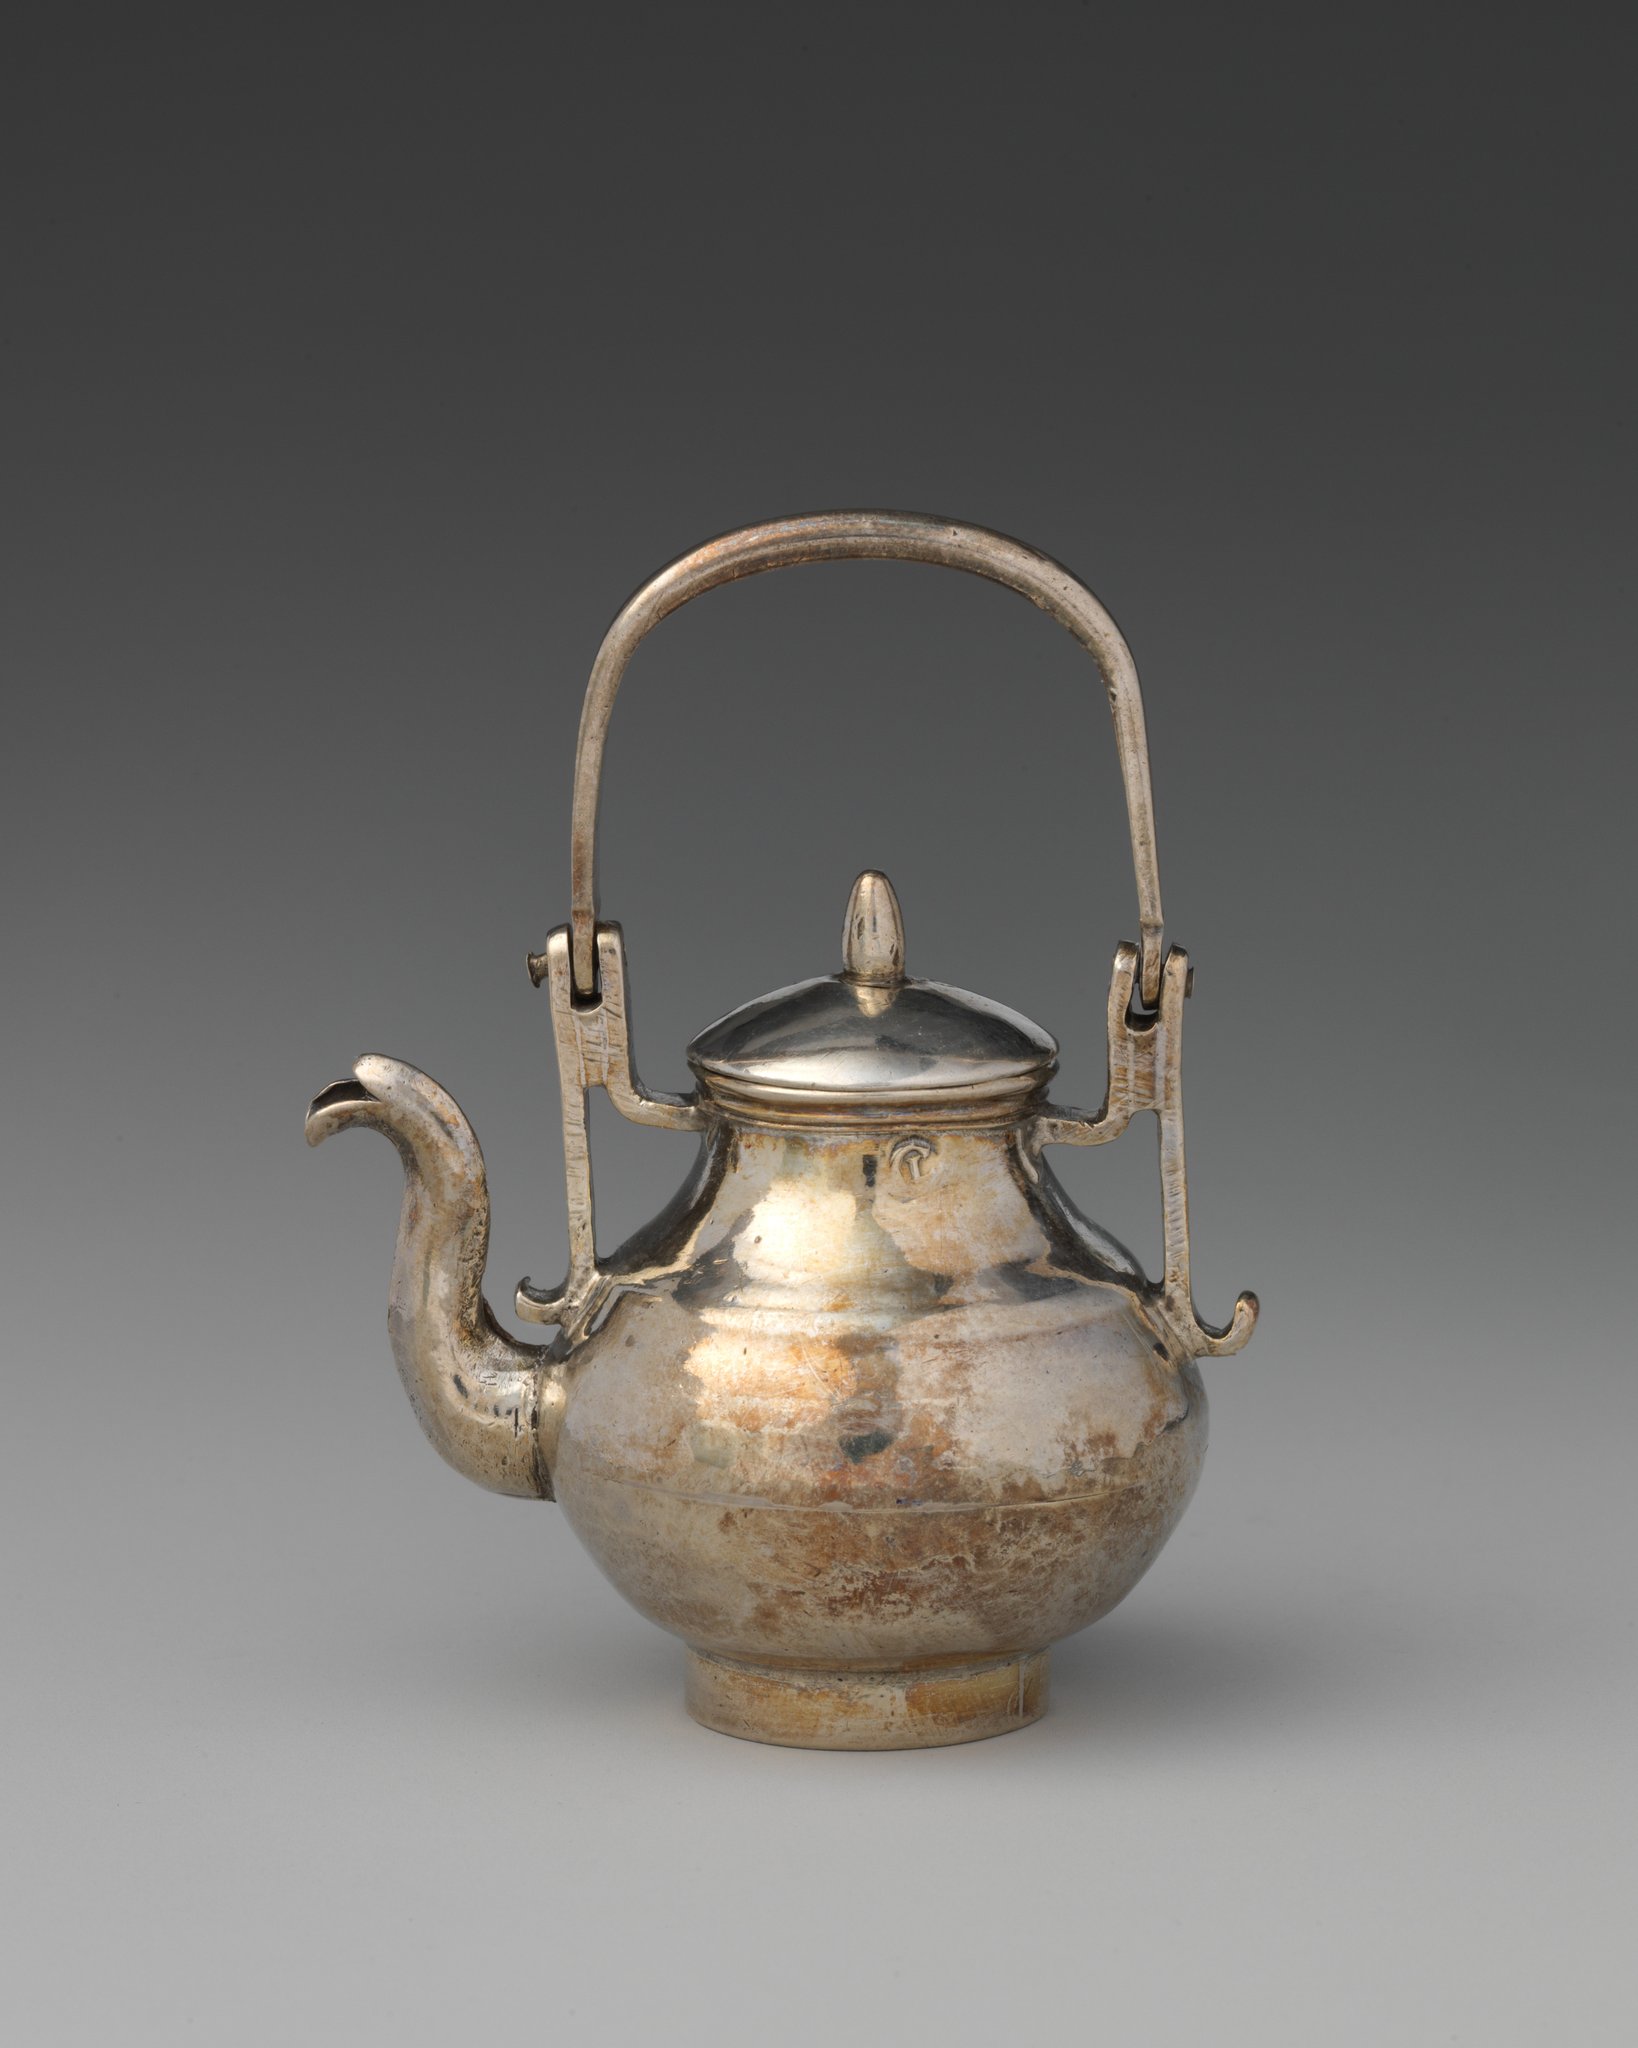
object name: kettle with cover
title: Miniature kettle with cover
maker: david clayton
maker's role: maker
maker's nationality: british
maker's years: 1659-1719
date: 1667-1733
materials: silver